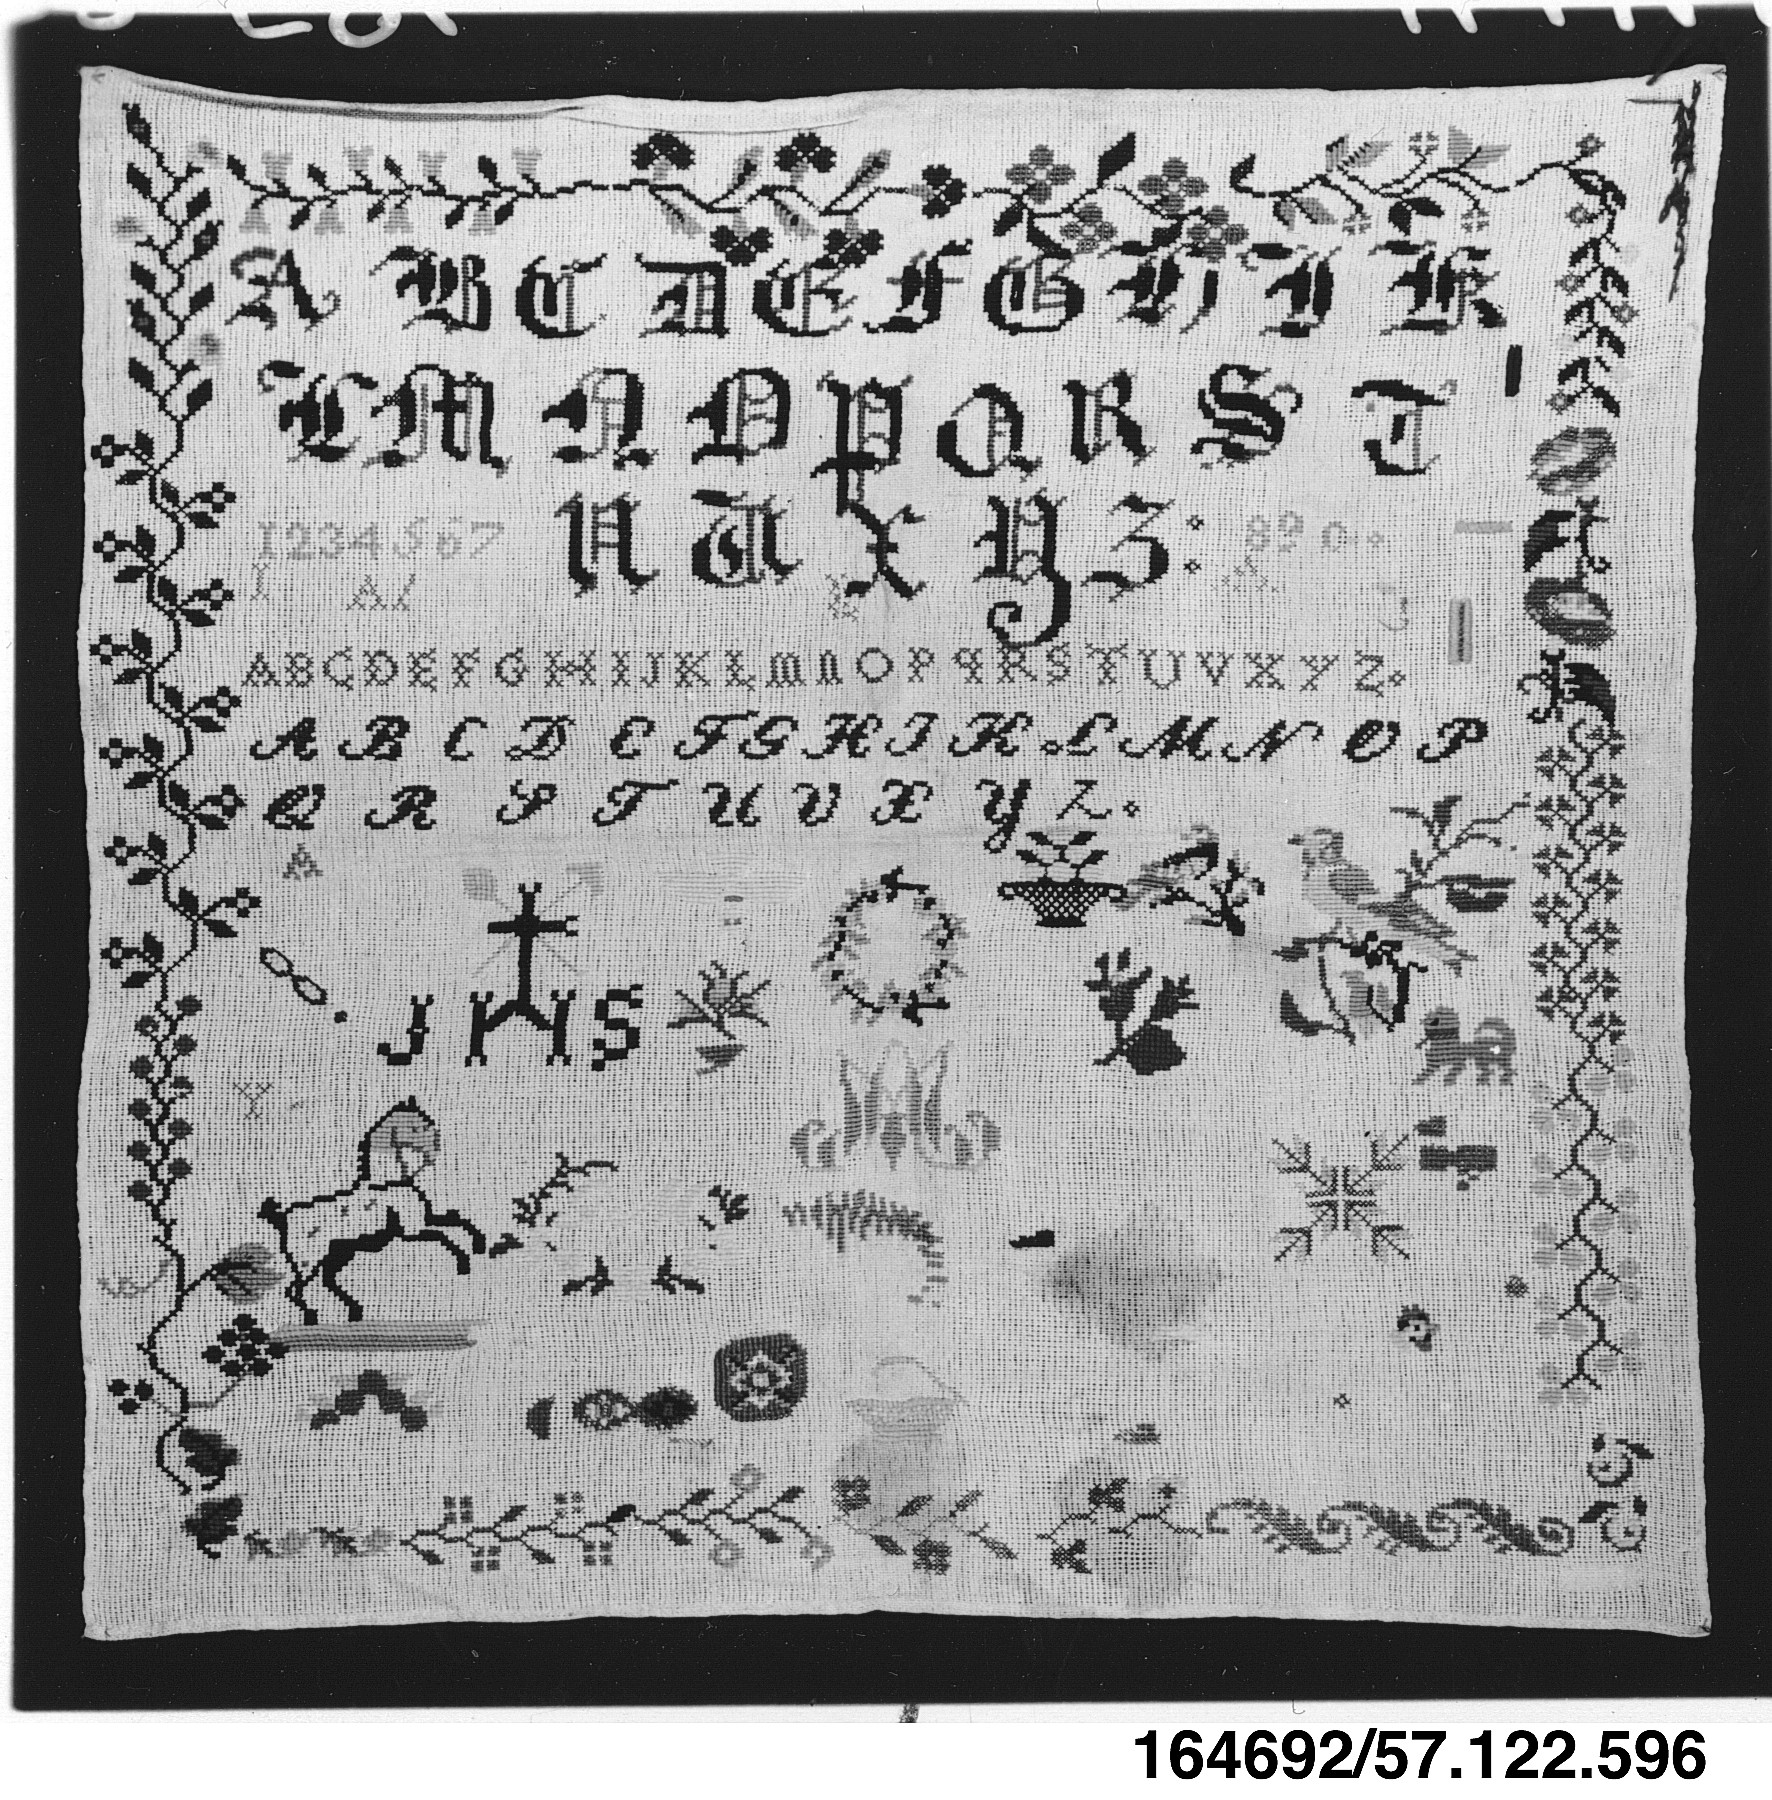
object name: sampler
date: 1801-1900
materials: canvas, cotton, wool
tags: birds,horses